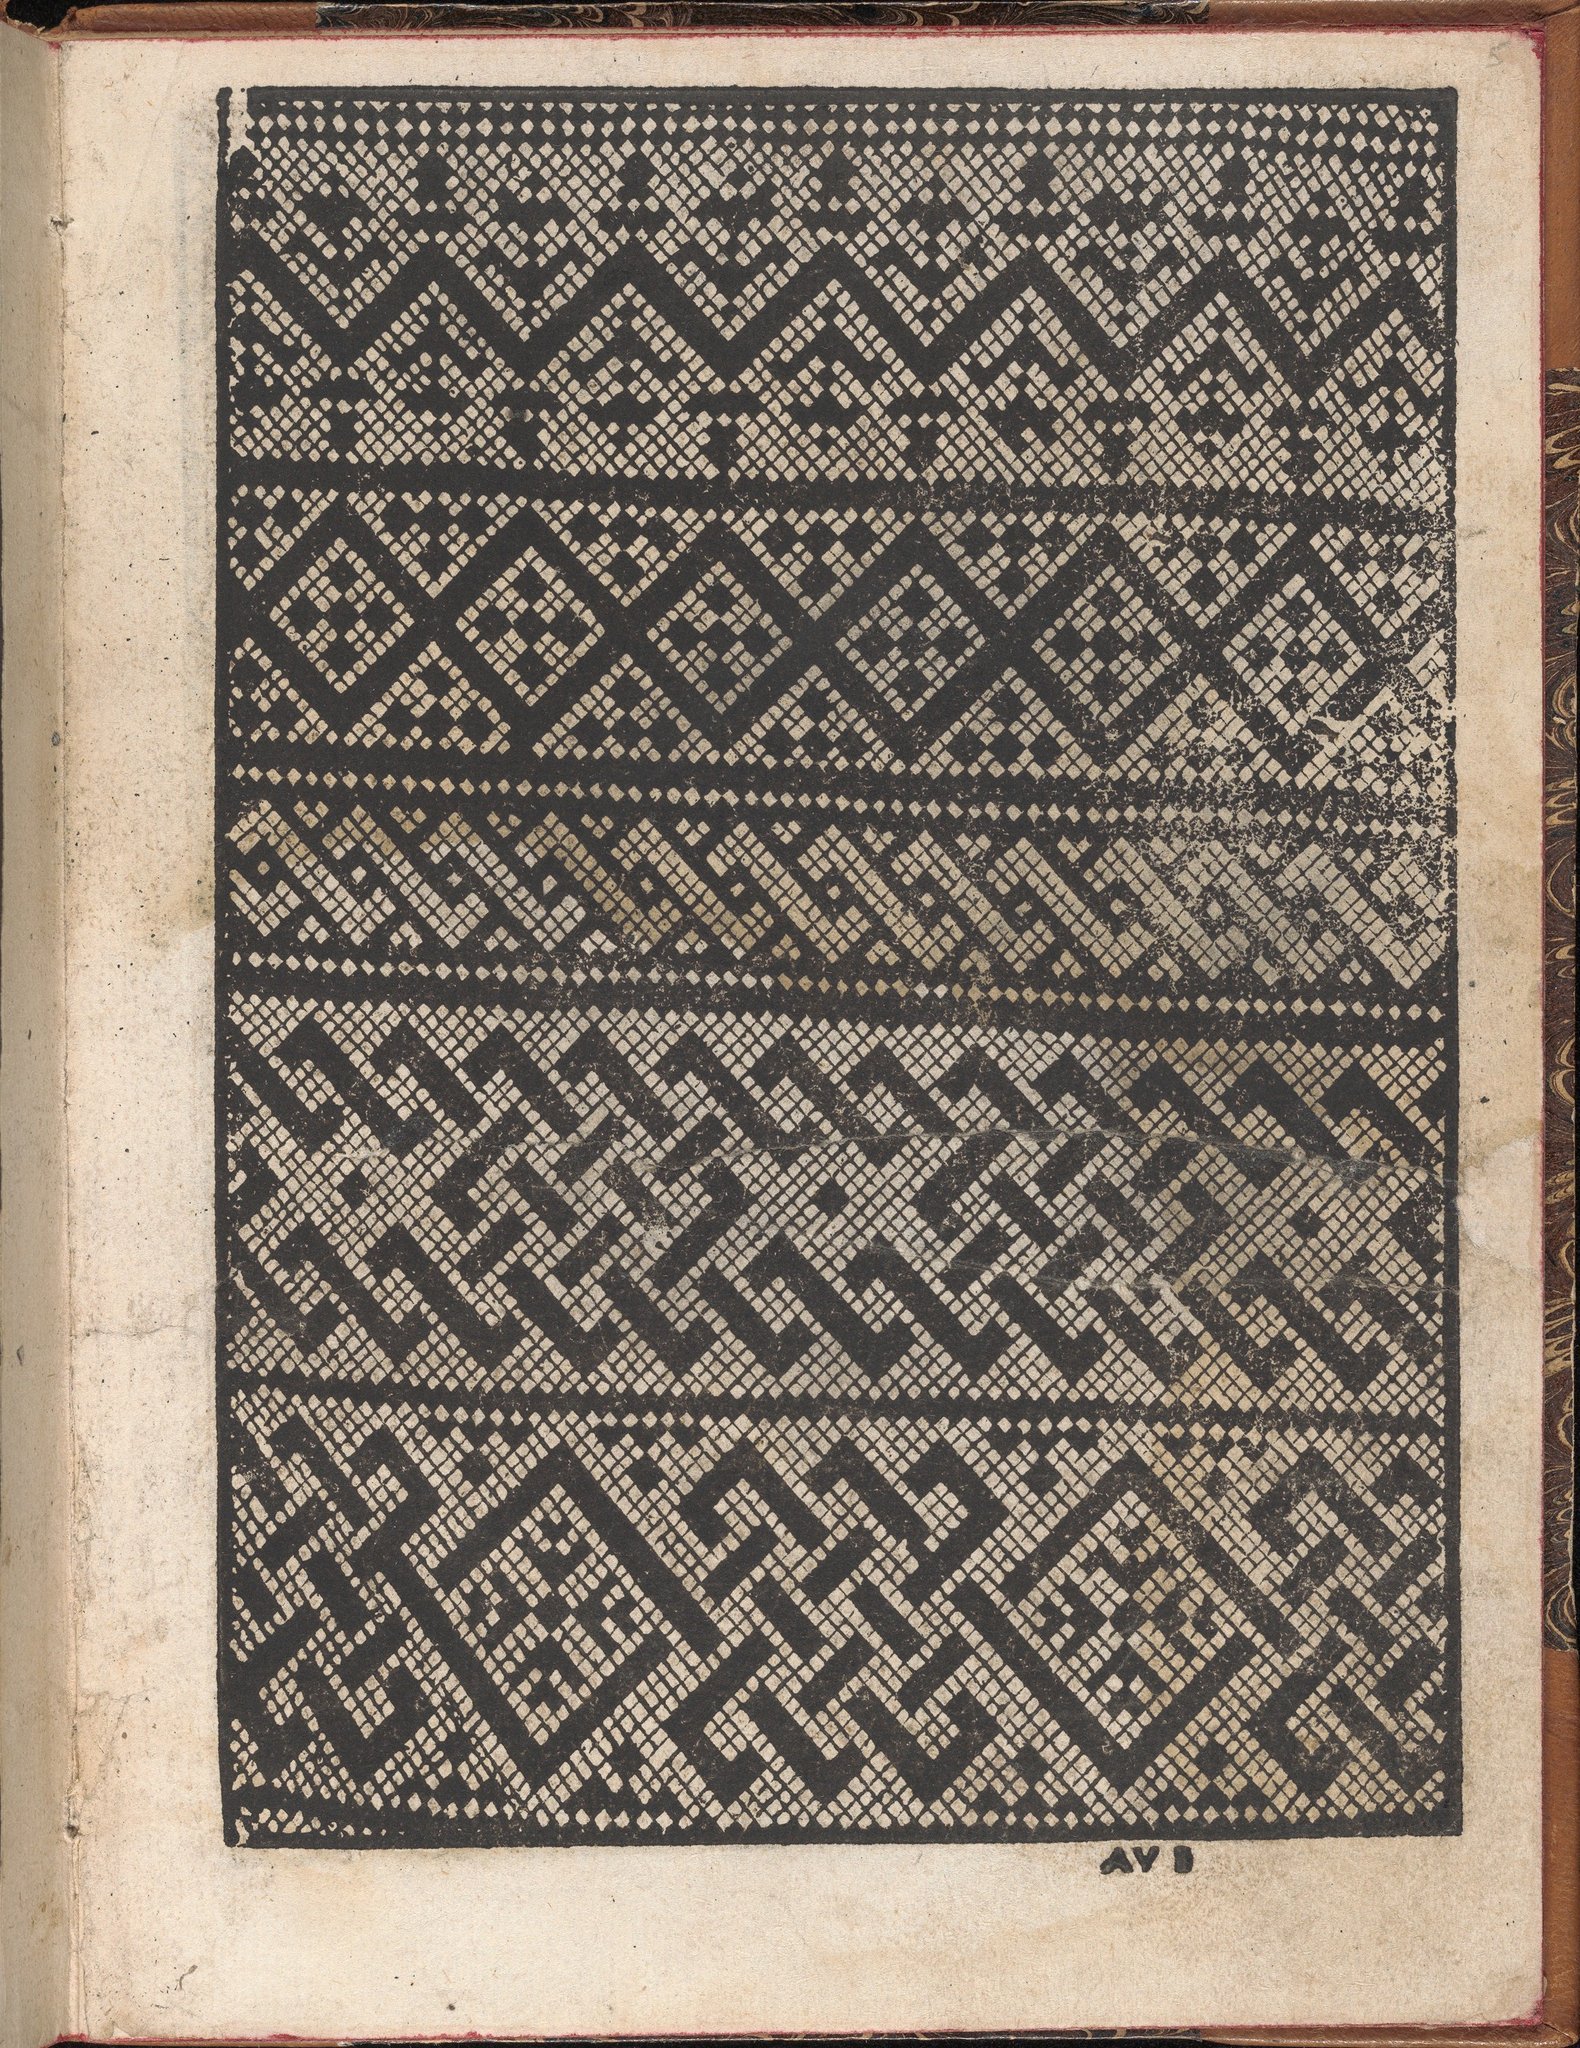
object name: book print ornament architecture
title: Spechio di pensieri delle belle et Virtudiose donne, page 5 (recto)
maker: matteo pagano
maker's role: publisher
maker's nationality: italian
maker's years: 1515-1588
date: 1546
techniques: woodcut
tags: ornament